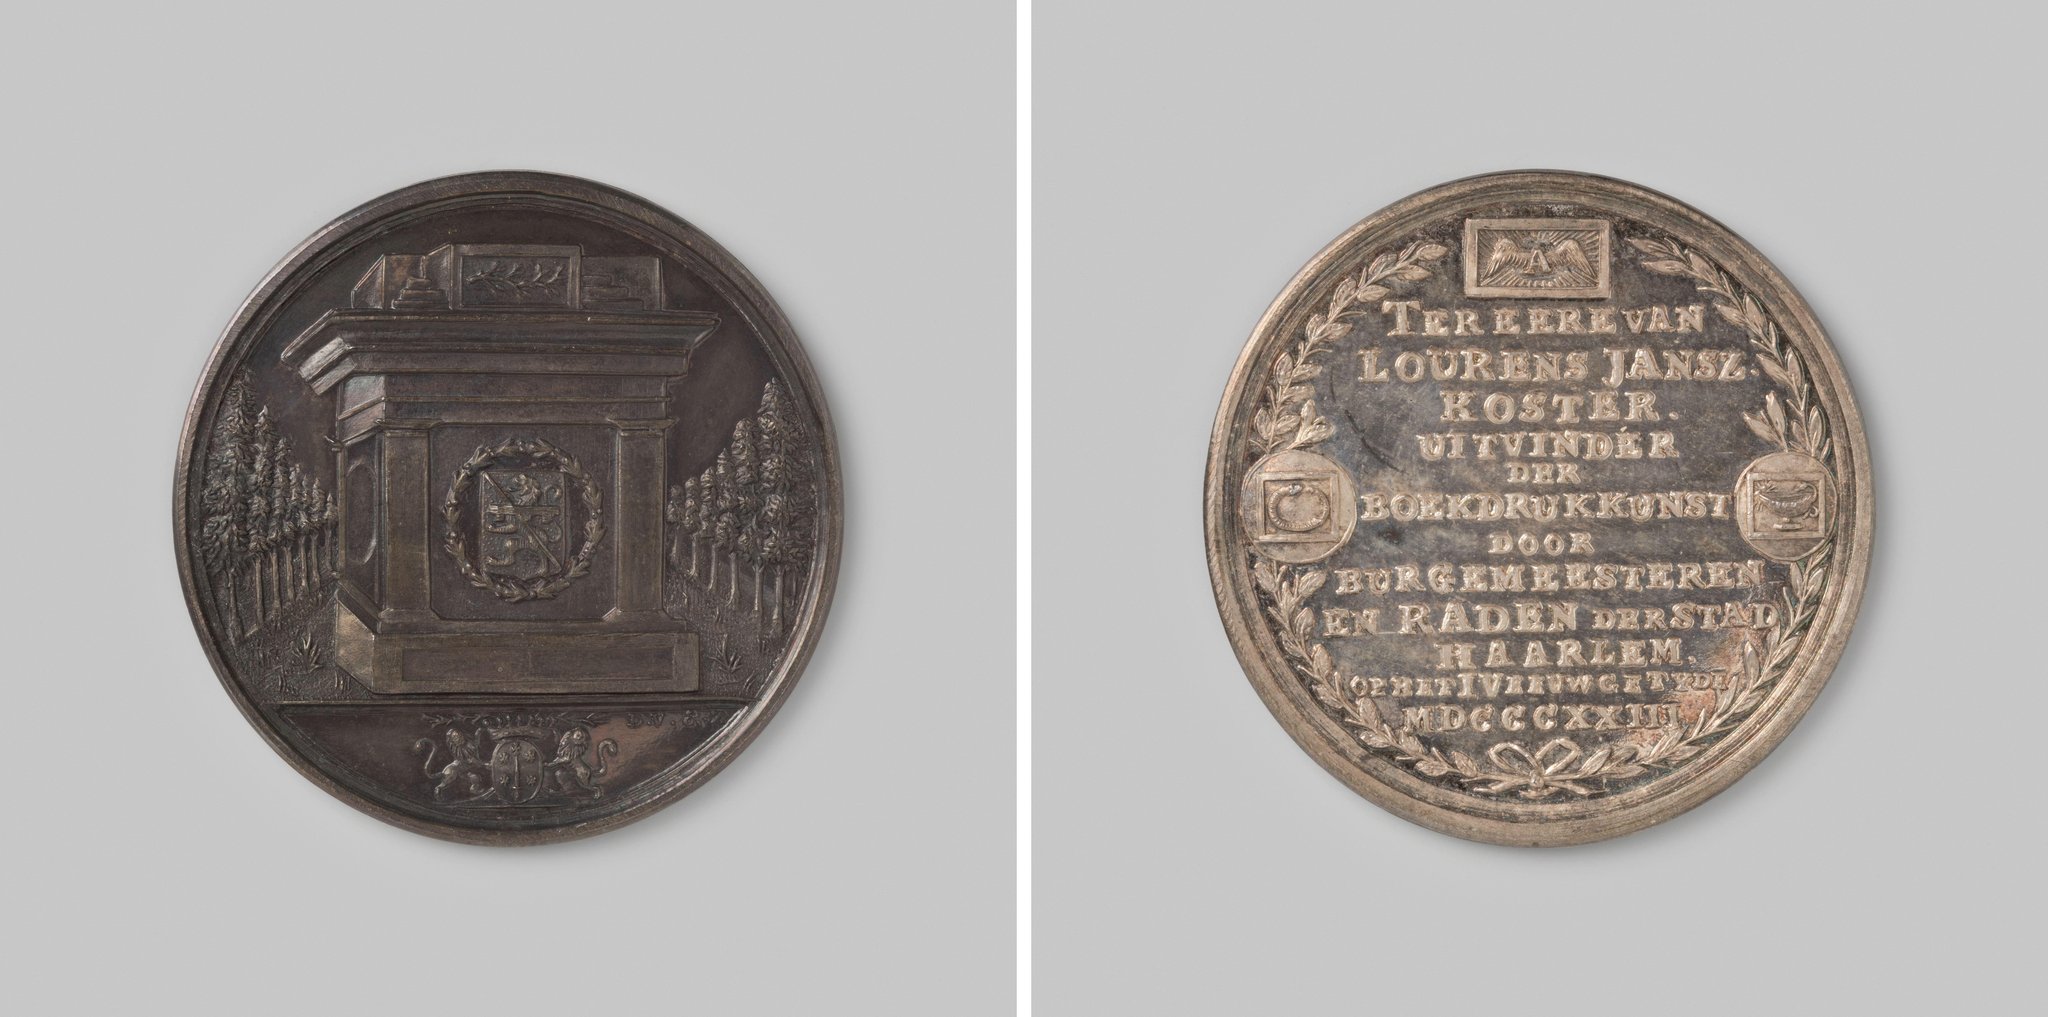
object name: history medal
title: Herdenking van de uitvinding van de boekdrukkunst in Haarlem 1823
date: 1823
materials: silver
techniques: striking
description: Zilveren penning, op de voorzijde het Costermonument te Haarlem, in afsnede het Haarlemse stadswapen met tenanten, op de keerzijde twaalf regels tekst onder een rechhoek met een gevleugelde letter A, tussen samengestrikte lauwertakken waarop borden met een slangenrond en een olielamp.